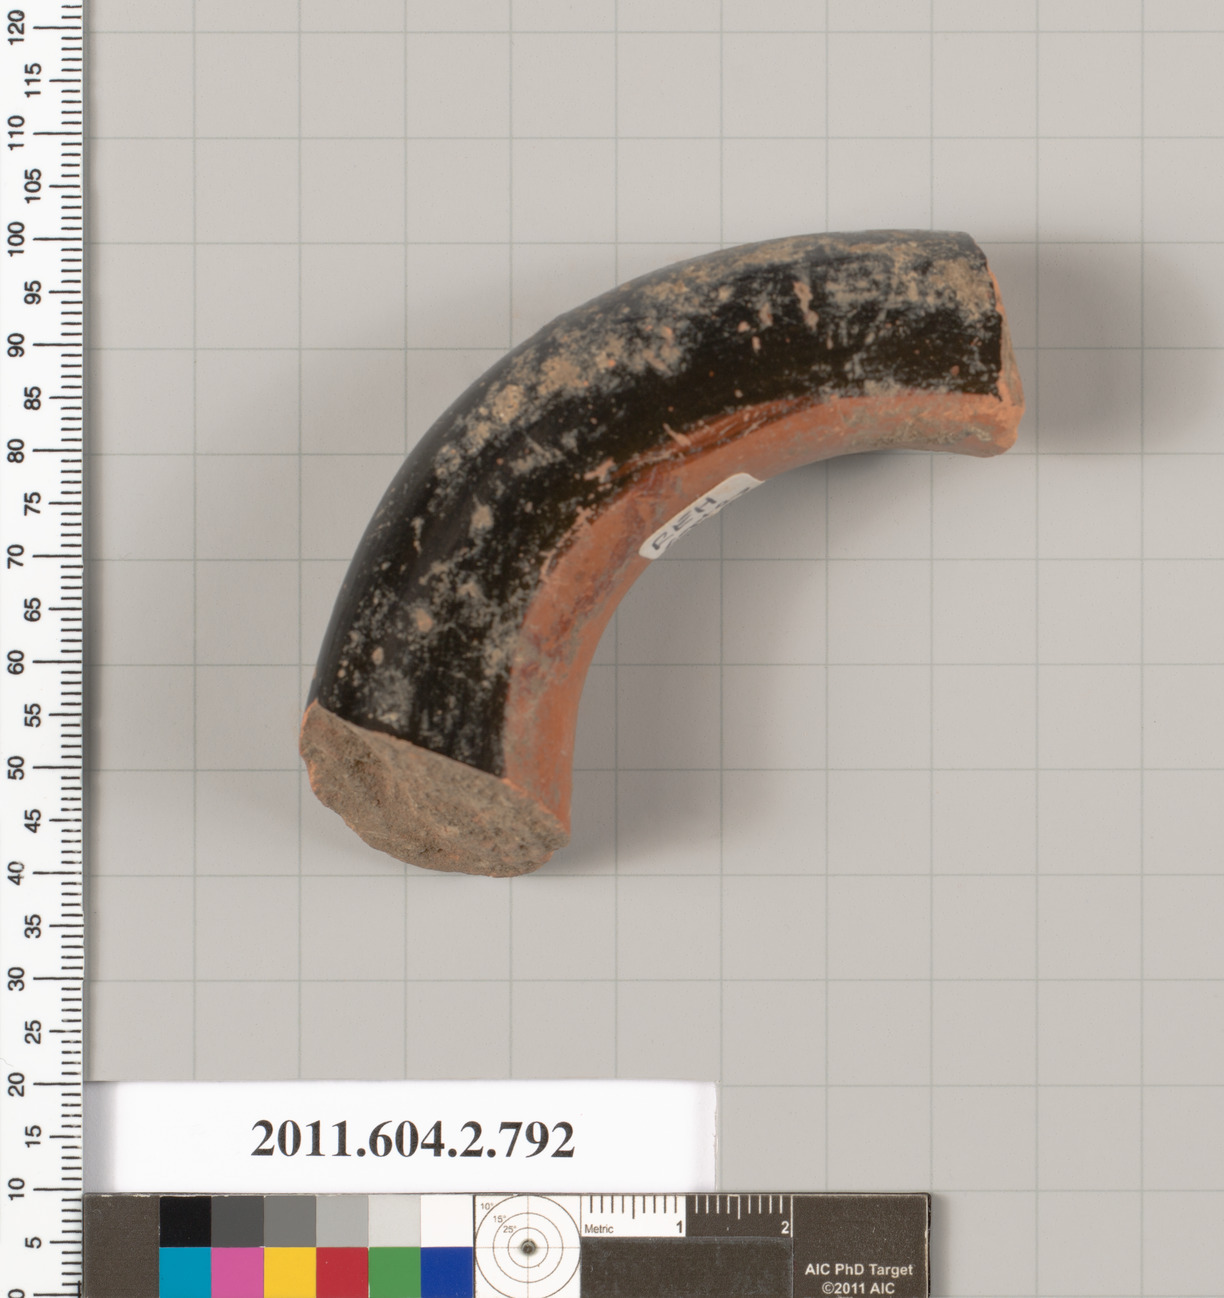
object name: calyx krater fragment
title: Terracotta fragment of a calyx-krater (bowl for mixing wine and water)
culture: greek, attic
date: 475-451 BCE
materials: terracotta